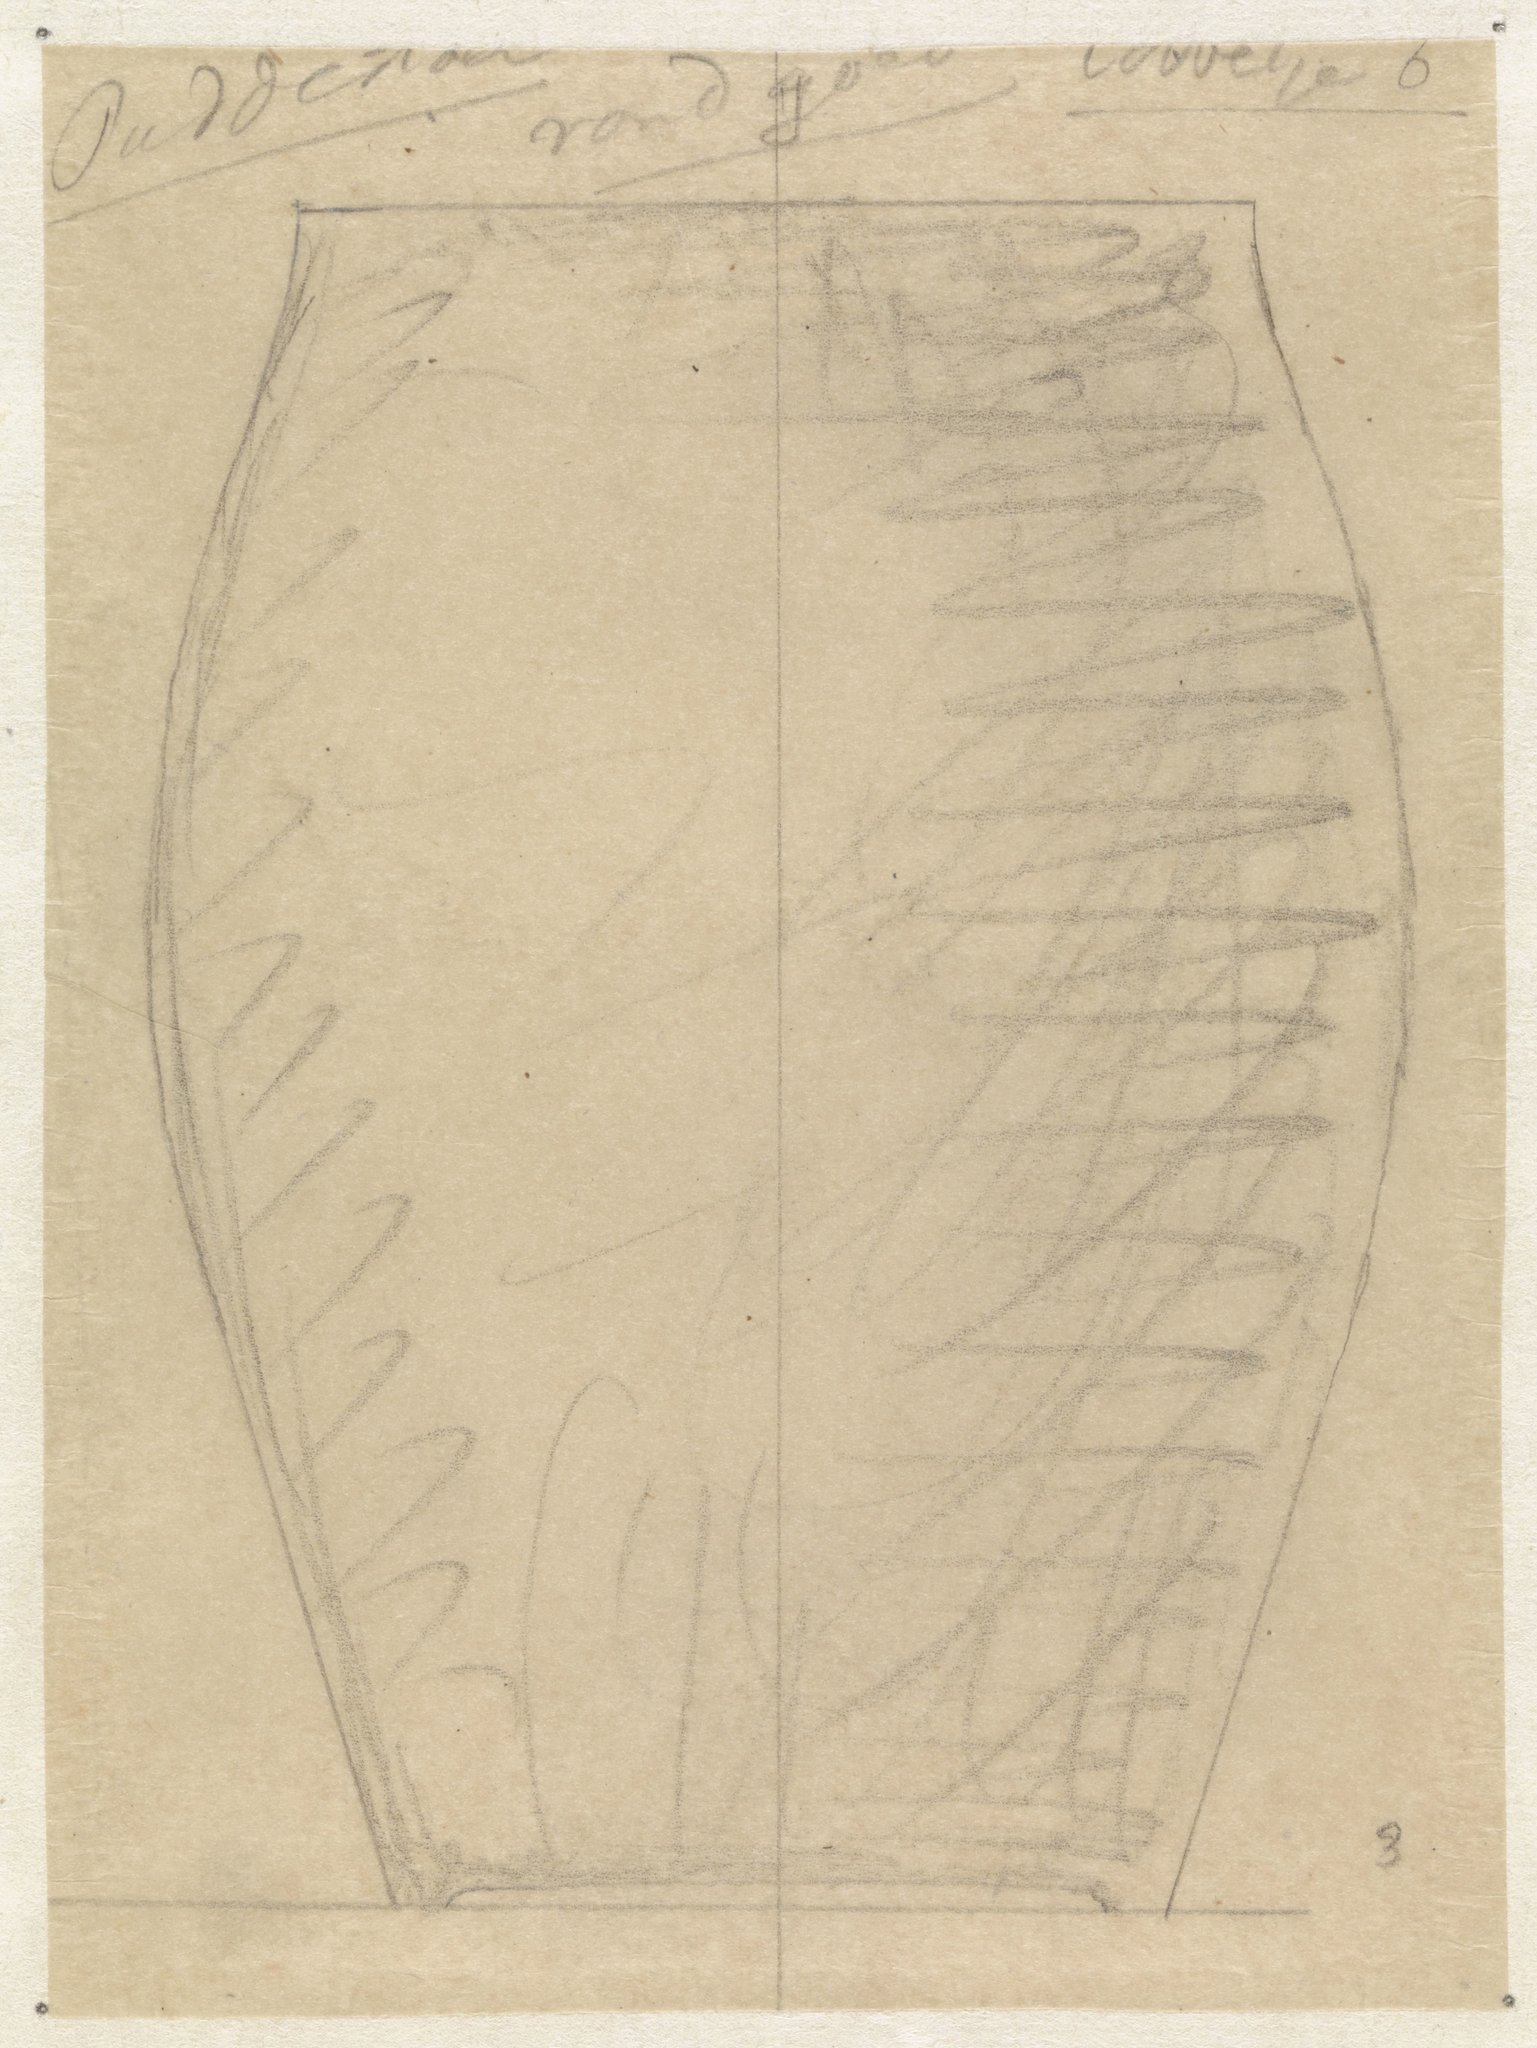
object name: drawing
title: Ontwerp voor een vaas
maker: theo colenbrander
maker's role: draughtsman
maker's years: 1841-1930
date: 1851-1930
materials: pencil, paper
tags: container of ceramics: jar, jug, pot, vase